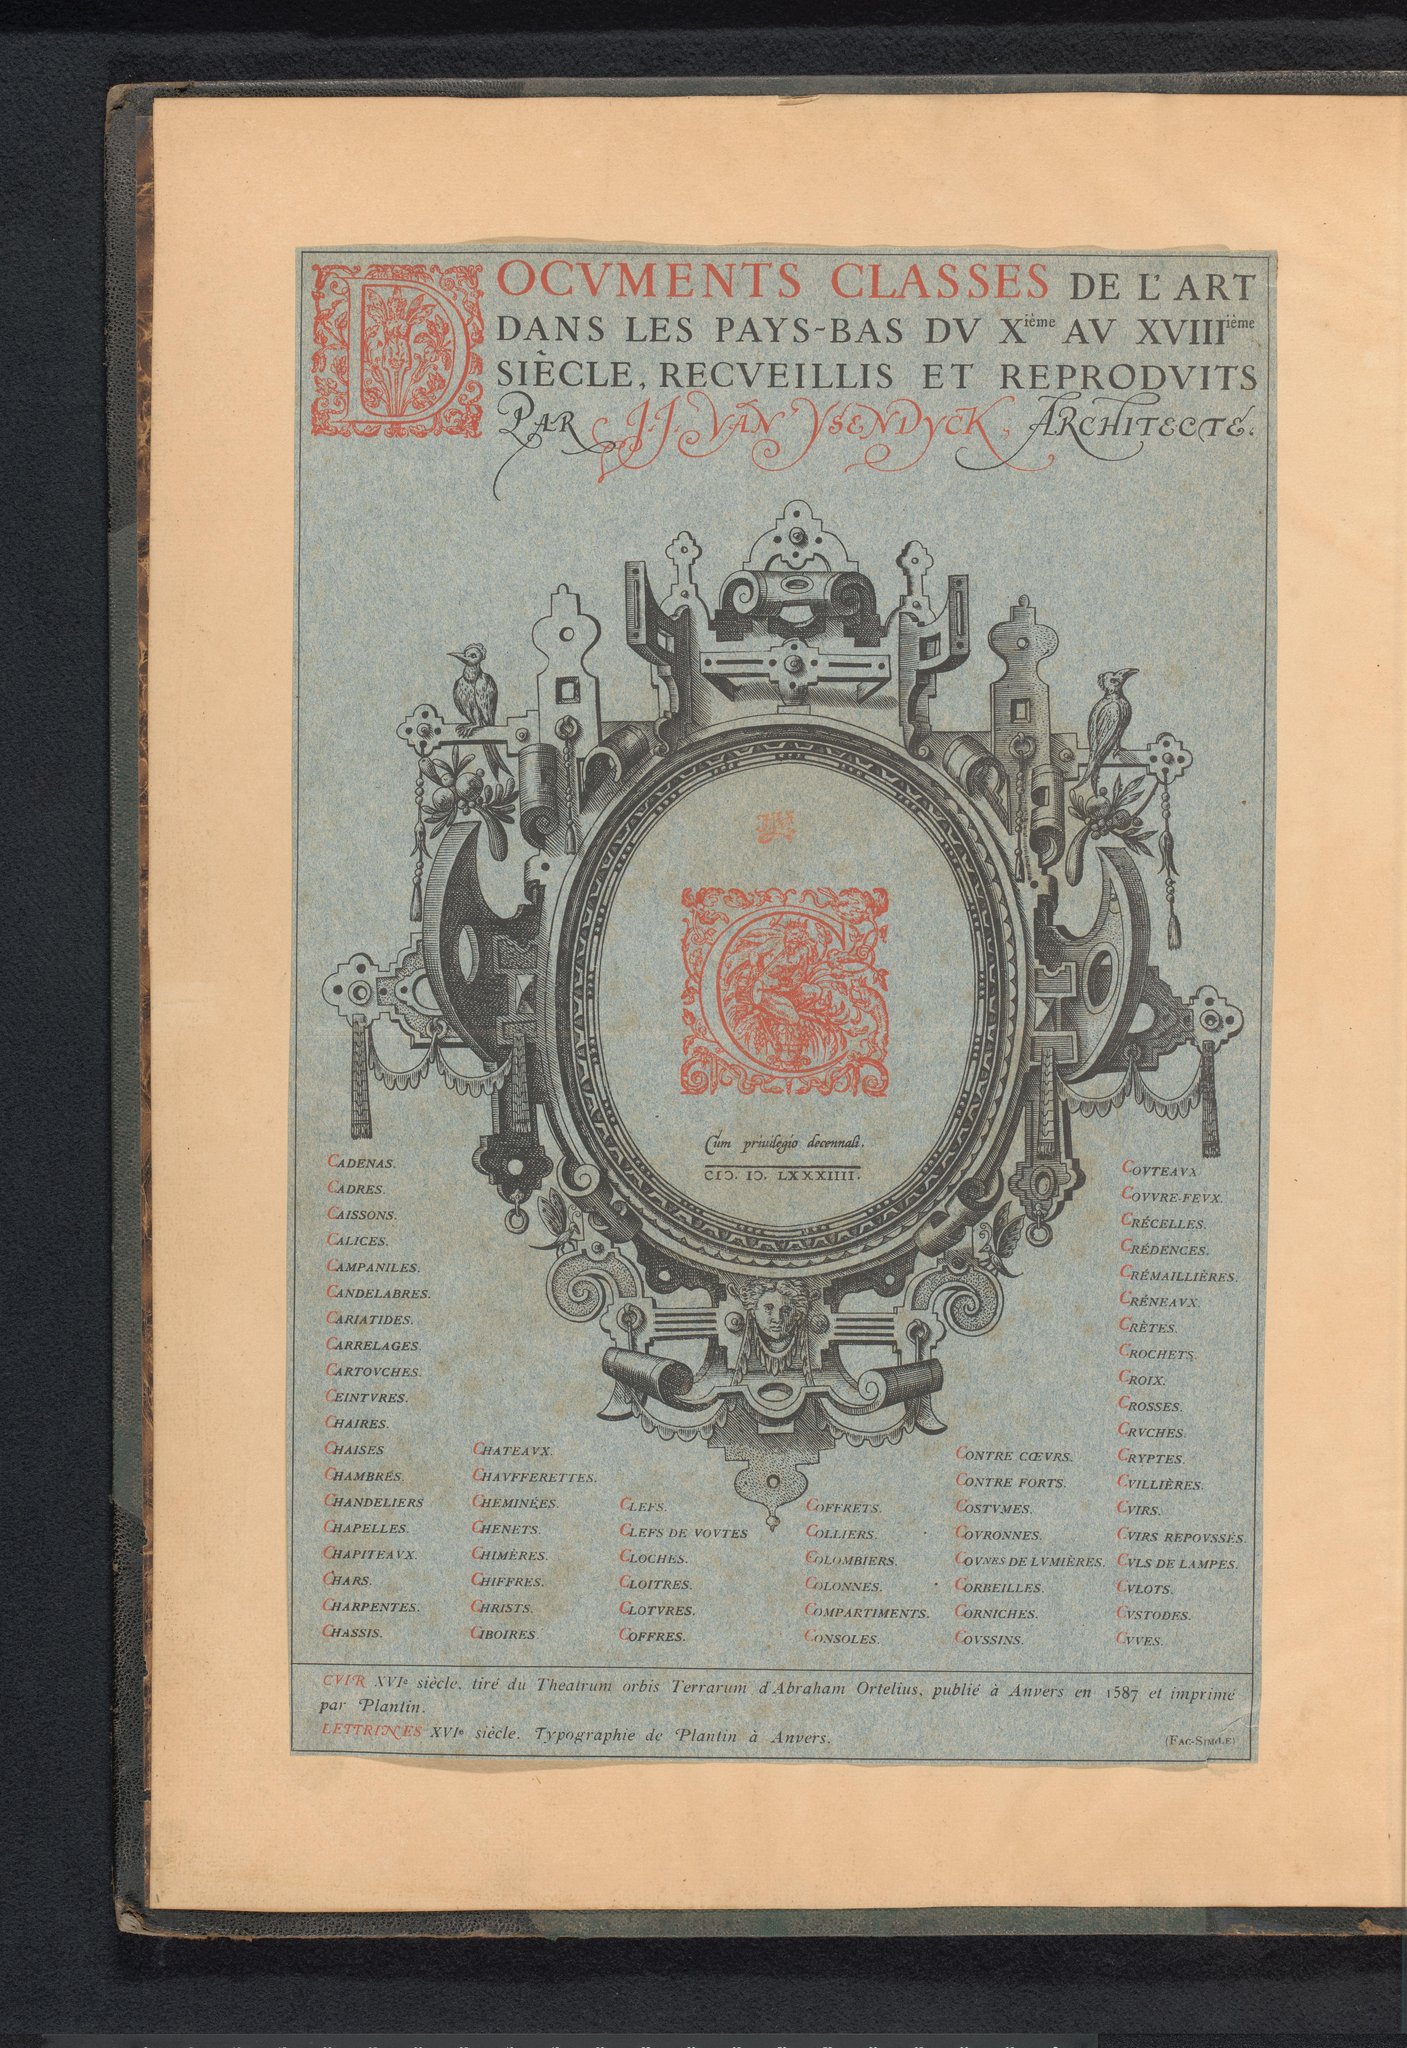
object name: photomechanical print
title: Reproductie van een titelpagina uit een atlas van Abraham Ortelius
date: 1875-1880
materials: paper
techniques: photolithography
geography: antwerp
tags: title-page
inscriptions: monogram: ‘JJvY’, inscription: ‘CVIR XVIe siècle (...)’